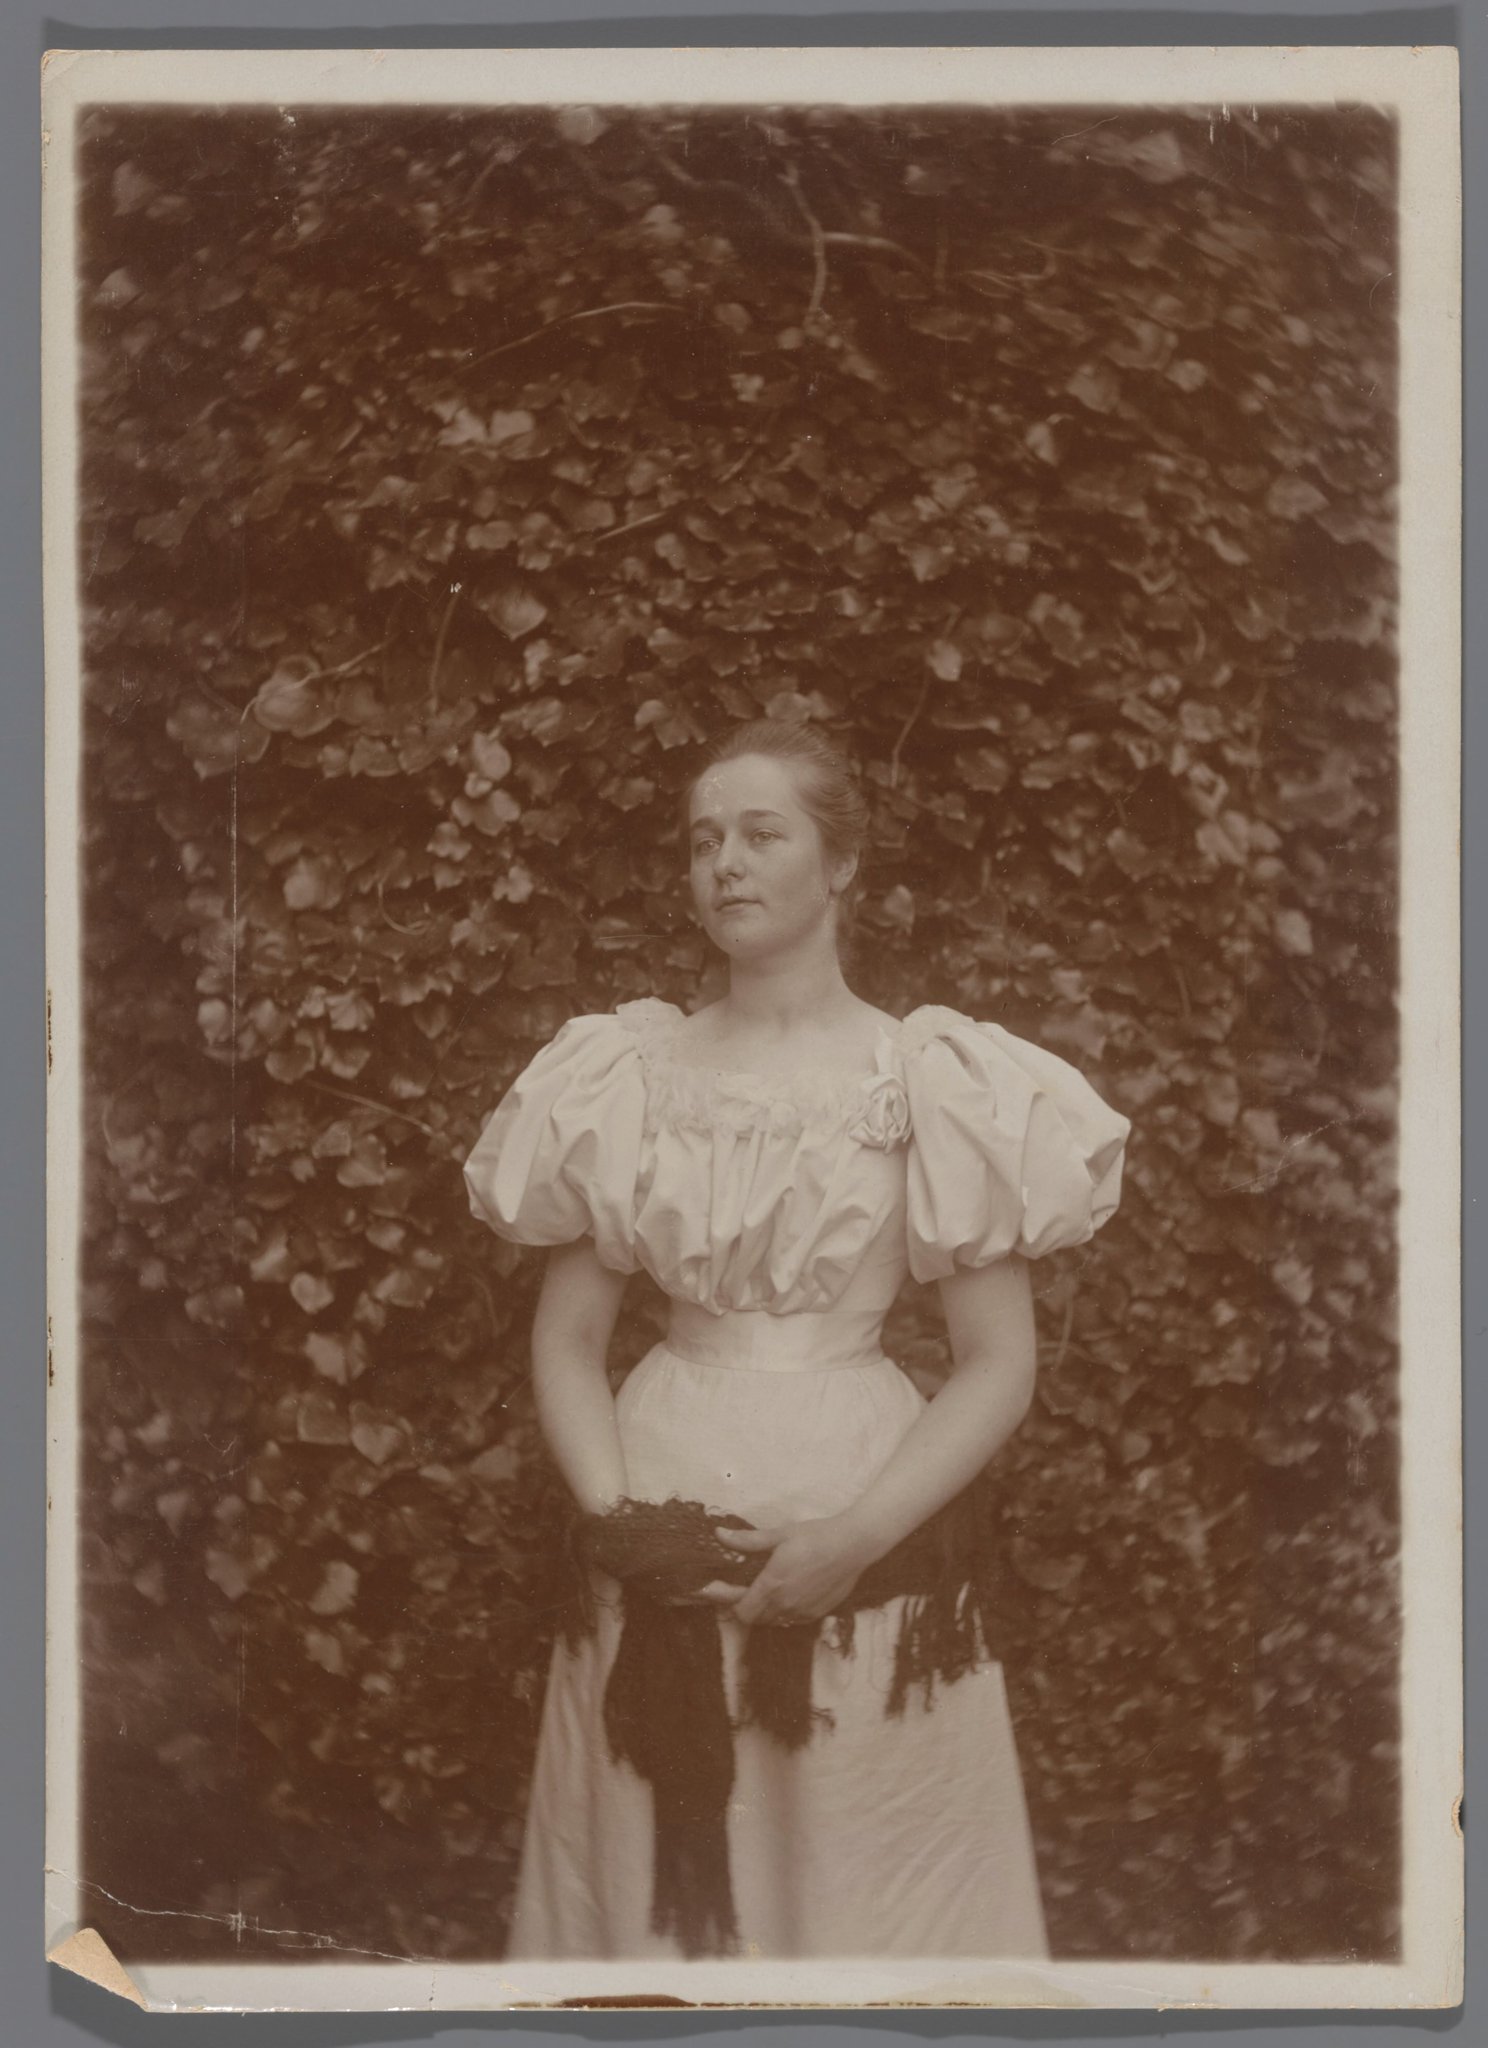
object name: photograph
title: Portret van Jennigje Hendrika Jacoba Jonker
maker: cornelia hendrika jonker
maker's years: 1874-1924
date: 1890-1920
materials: photographic support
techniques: collodion silver print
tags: historical persons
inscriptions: annotation: ‘Jen Jonker uitgangs japon’